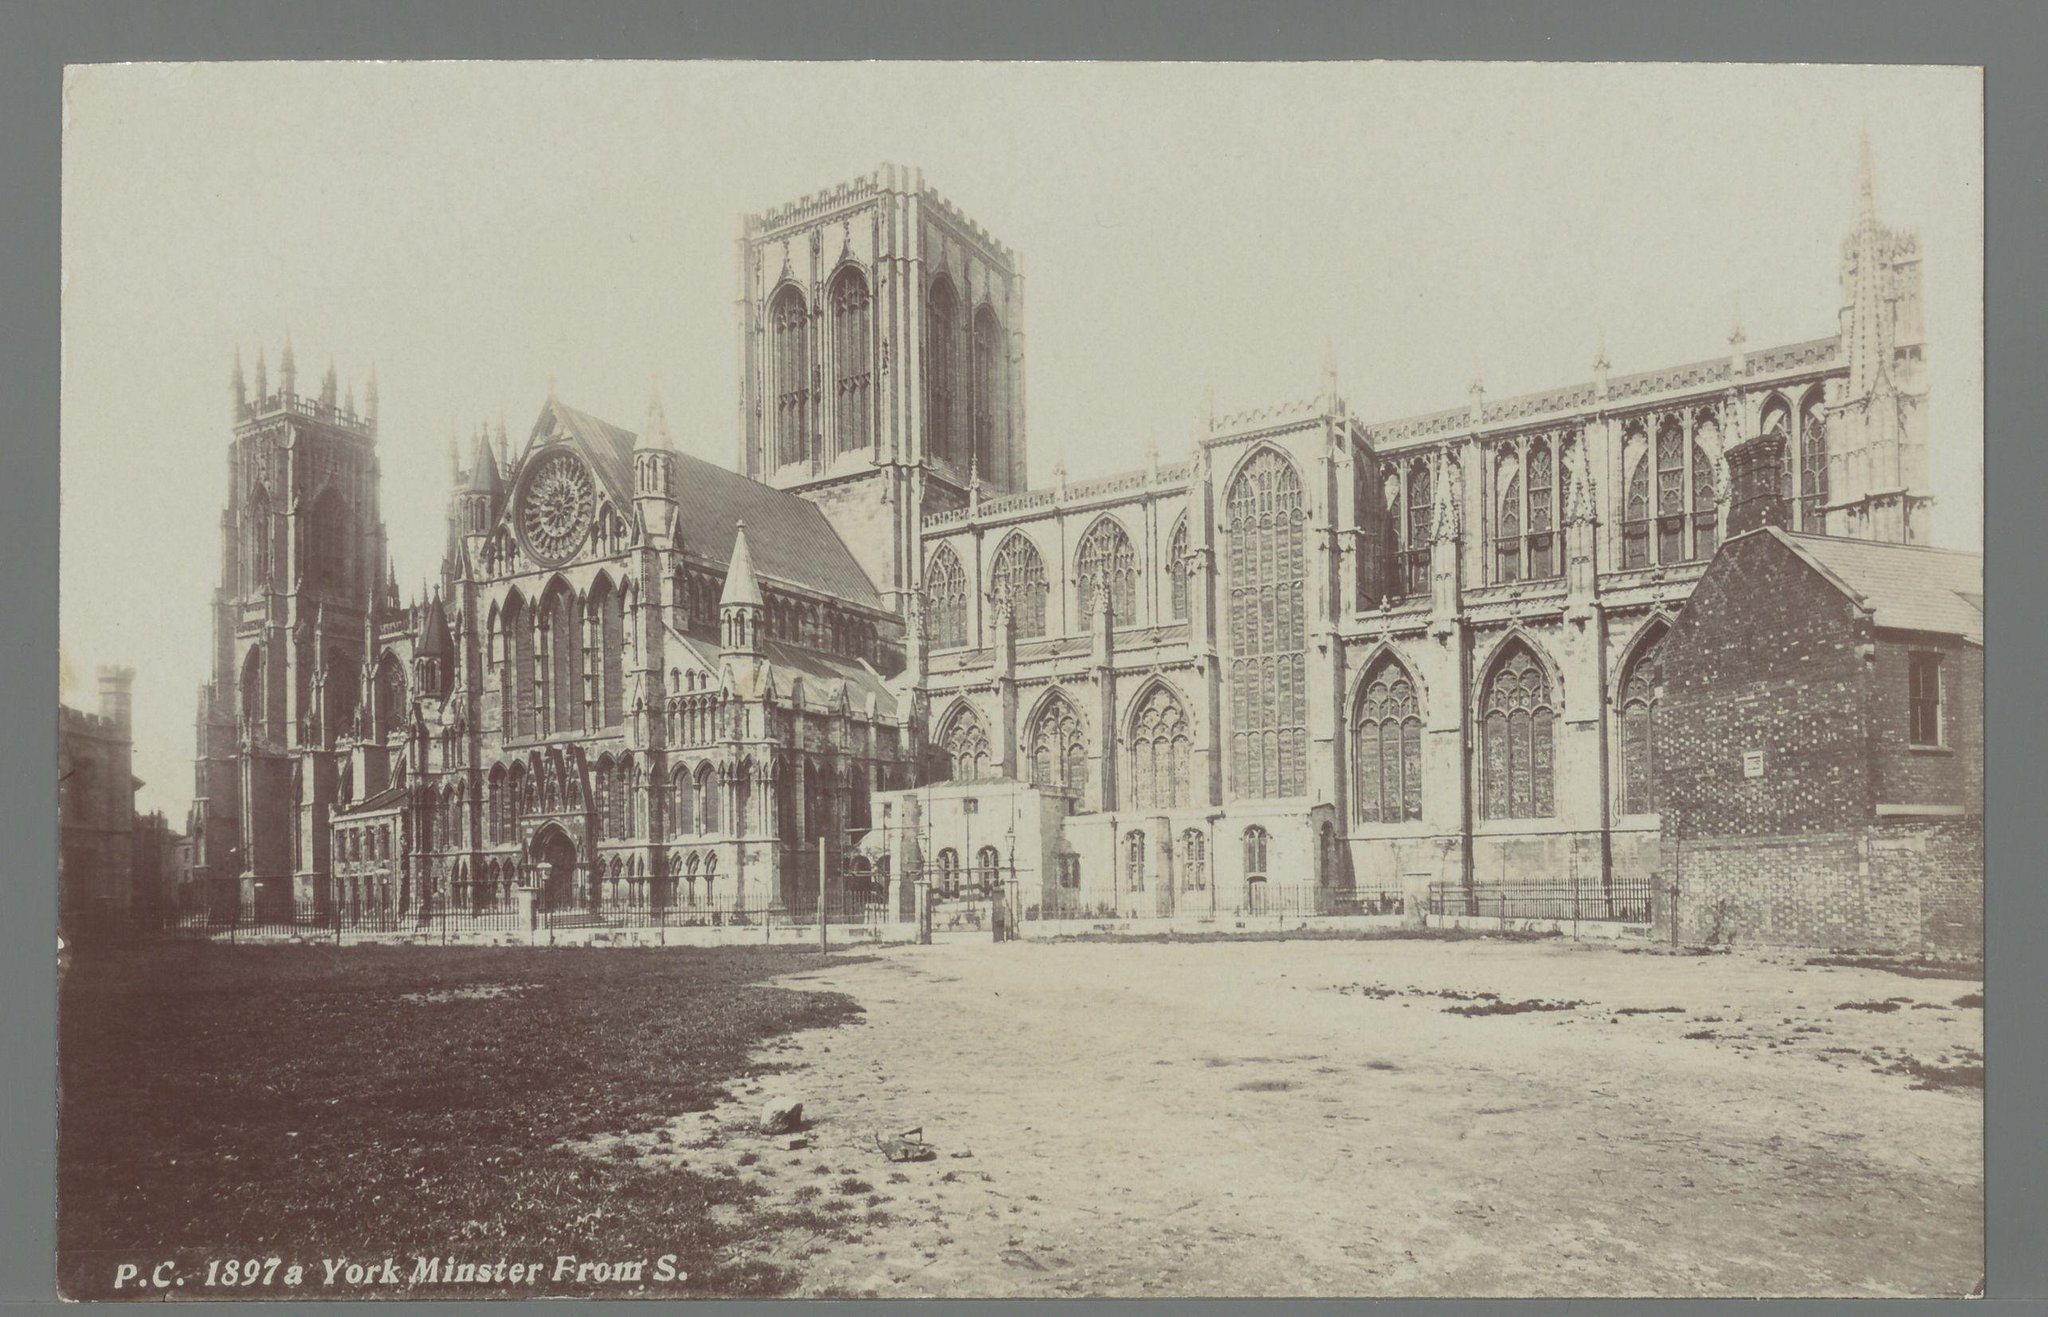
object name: photograph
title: York Minister from S.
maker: Anonymous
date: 1902-1918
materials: paper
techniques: gelatin silver print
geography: london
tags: church (exterior)